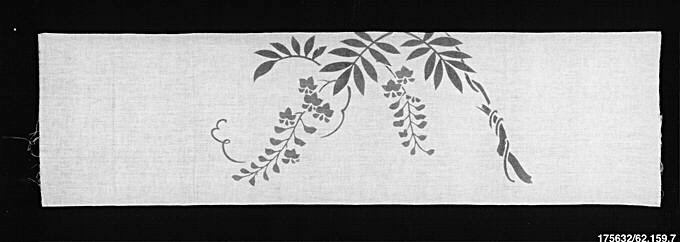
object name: strip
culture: japanese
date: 1901-1950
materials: cotton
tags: flowers